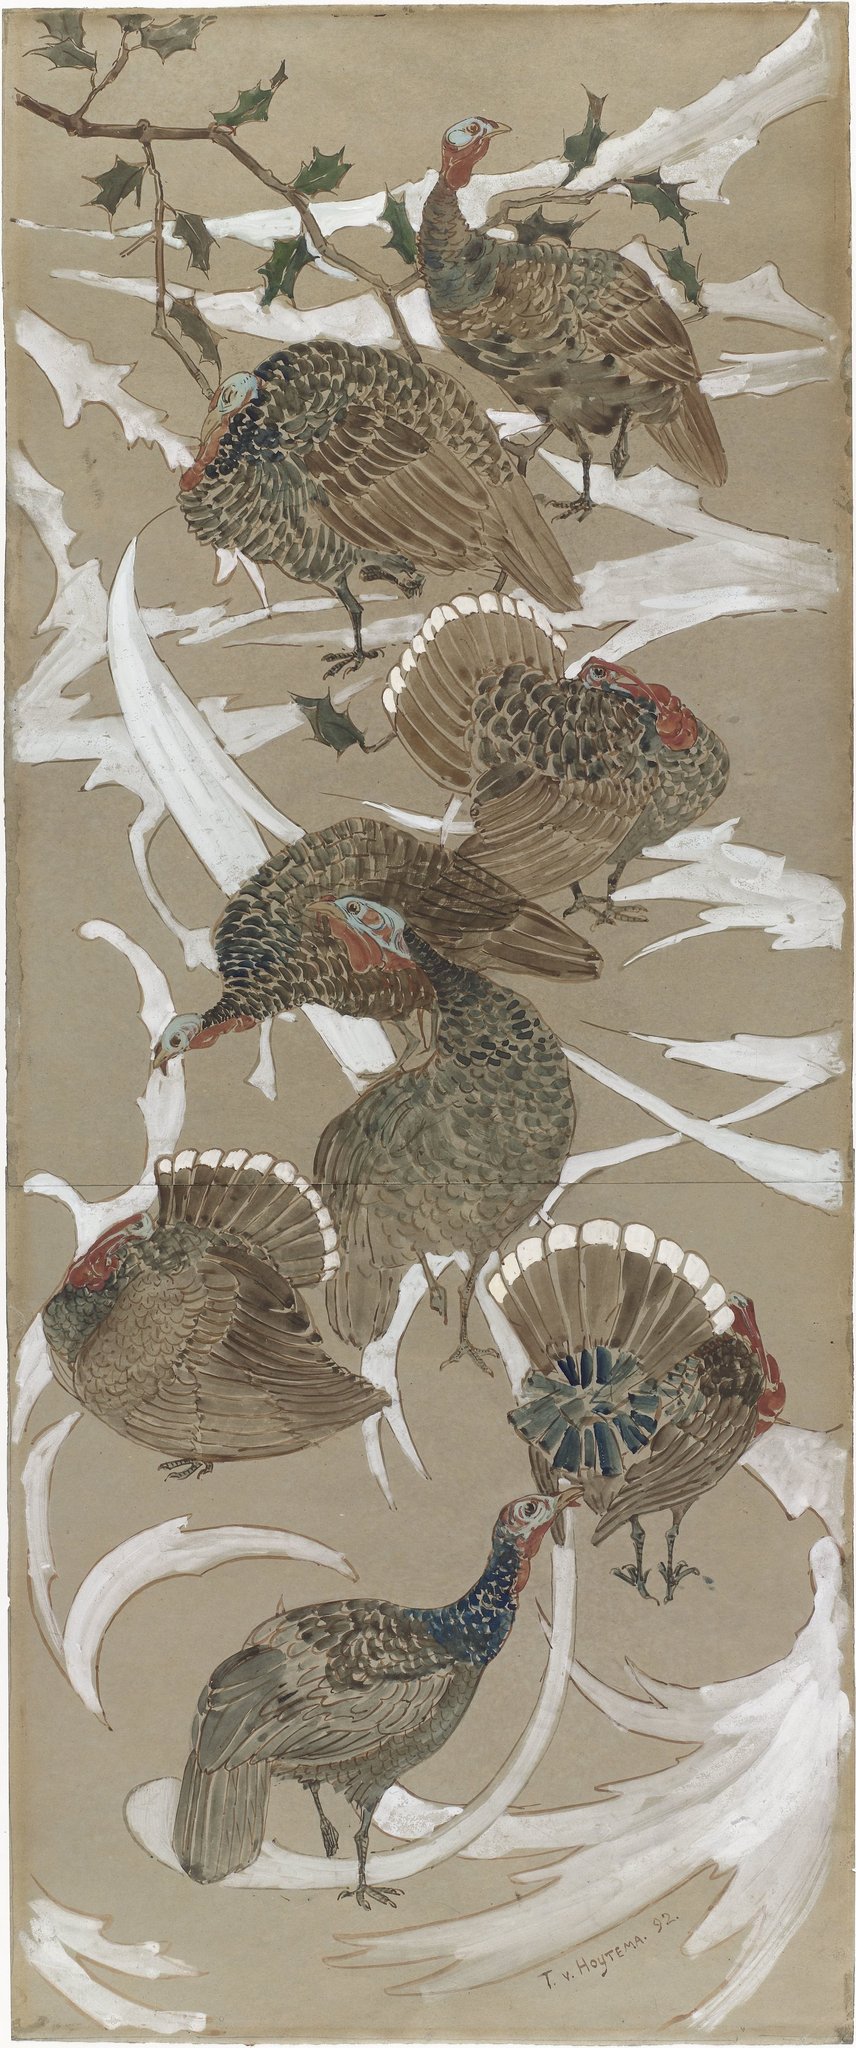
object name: drawing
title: Acht kalkoenen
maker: theo van hoytema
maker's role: draughtsman, painter, print maker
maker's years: 1863-1917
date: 1892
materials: paint, paper, watercolor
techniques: brush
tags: walker and runner birds: turkey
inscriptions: date: ‘92’